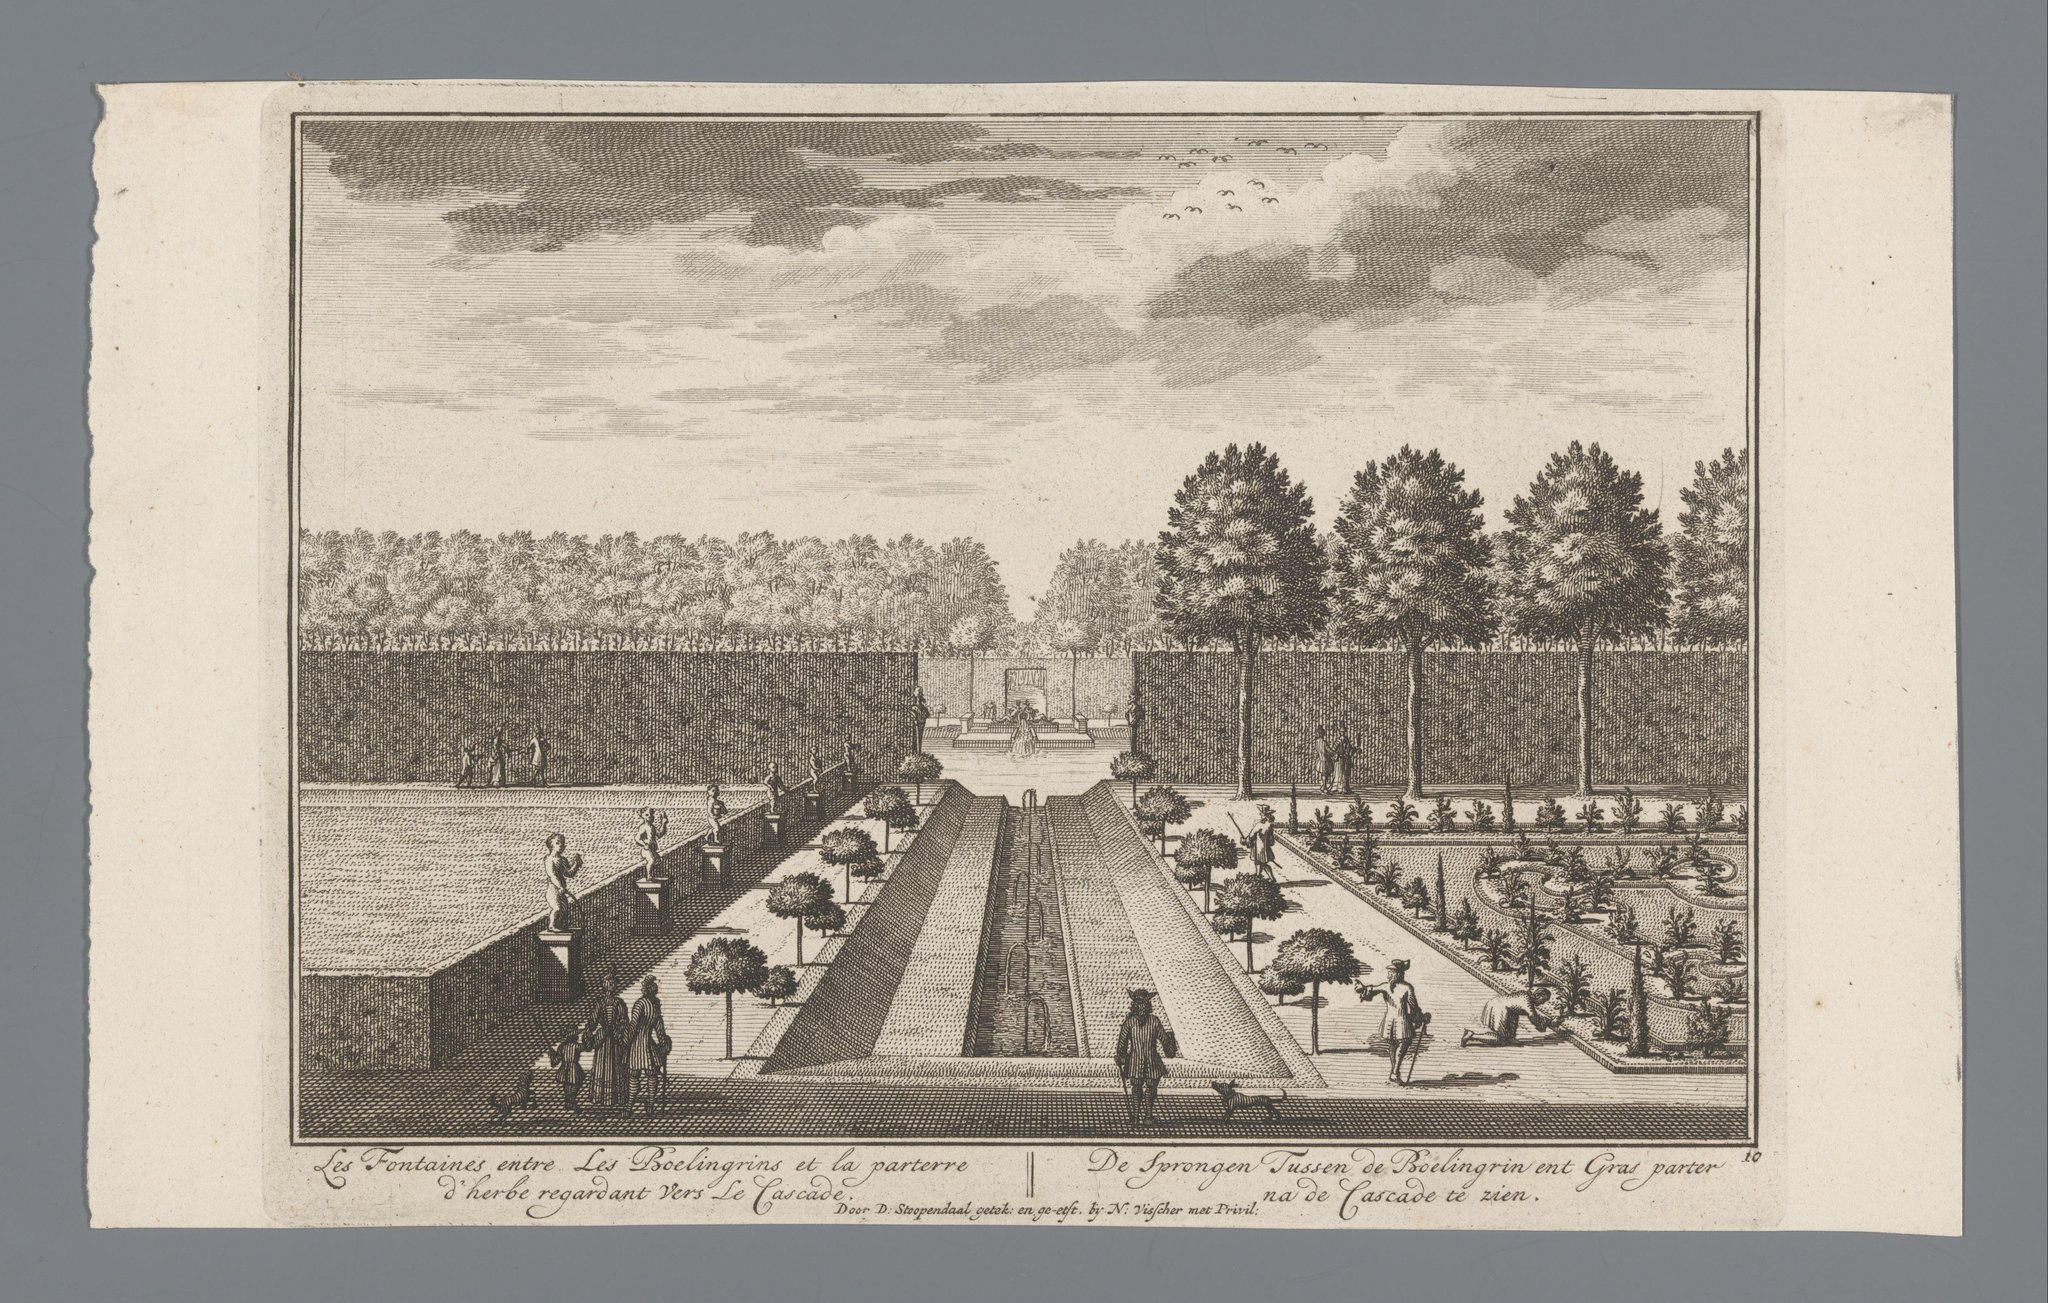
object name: print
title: Gezicht in de tuinen van Slot Zeist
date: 1682-1726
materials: paper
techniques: etching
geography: amsterdam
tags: castle, landscape with tower or castle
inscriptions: collector's mark: Lugt 2233